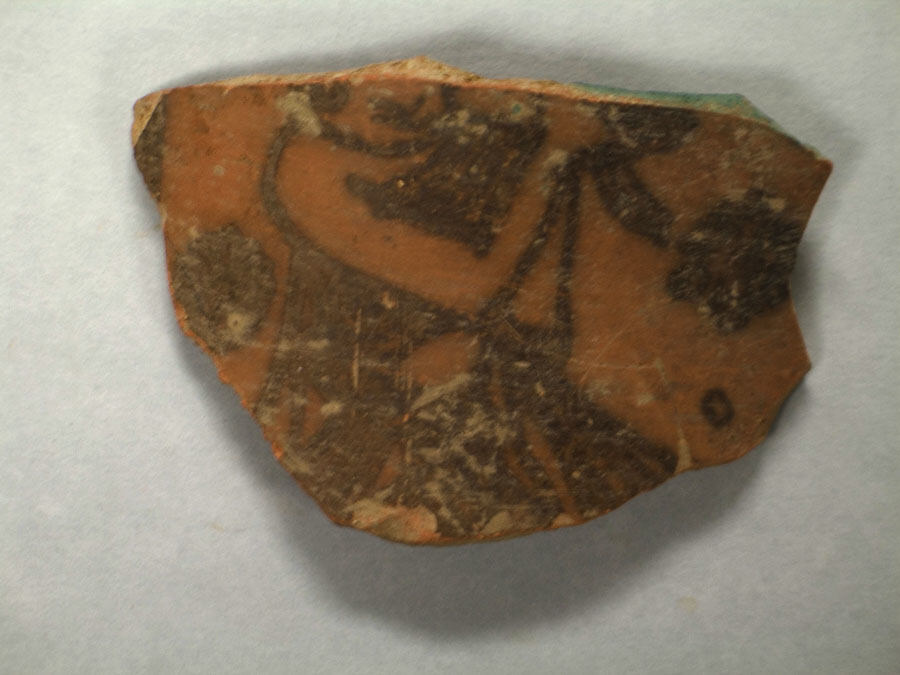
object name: shard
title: Shard: Torso of Offerer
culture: pakistani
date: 301-500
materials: terracotta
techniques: painting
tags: gandhara